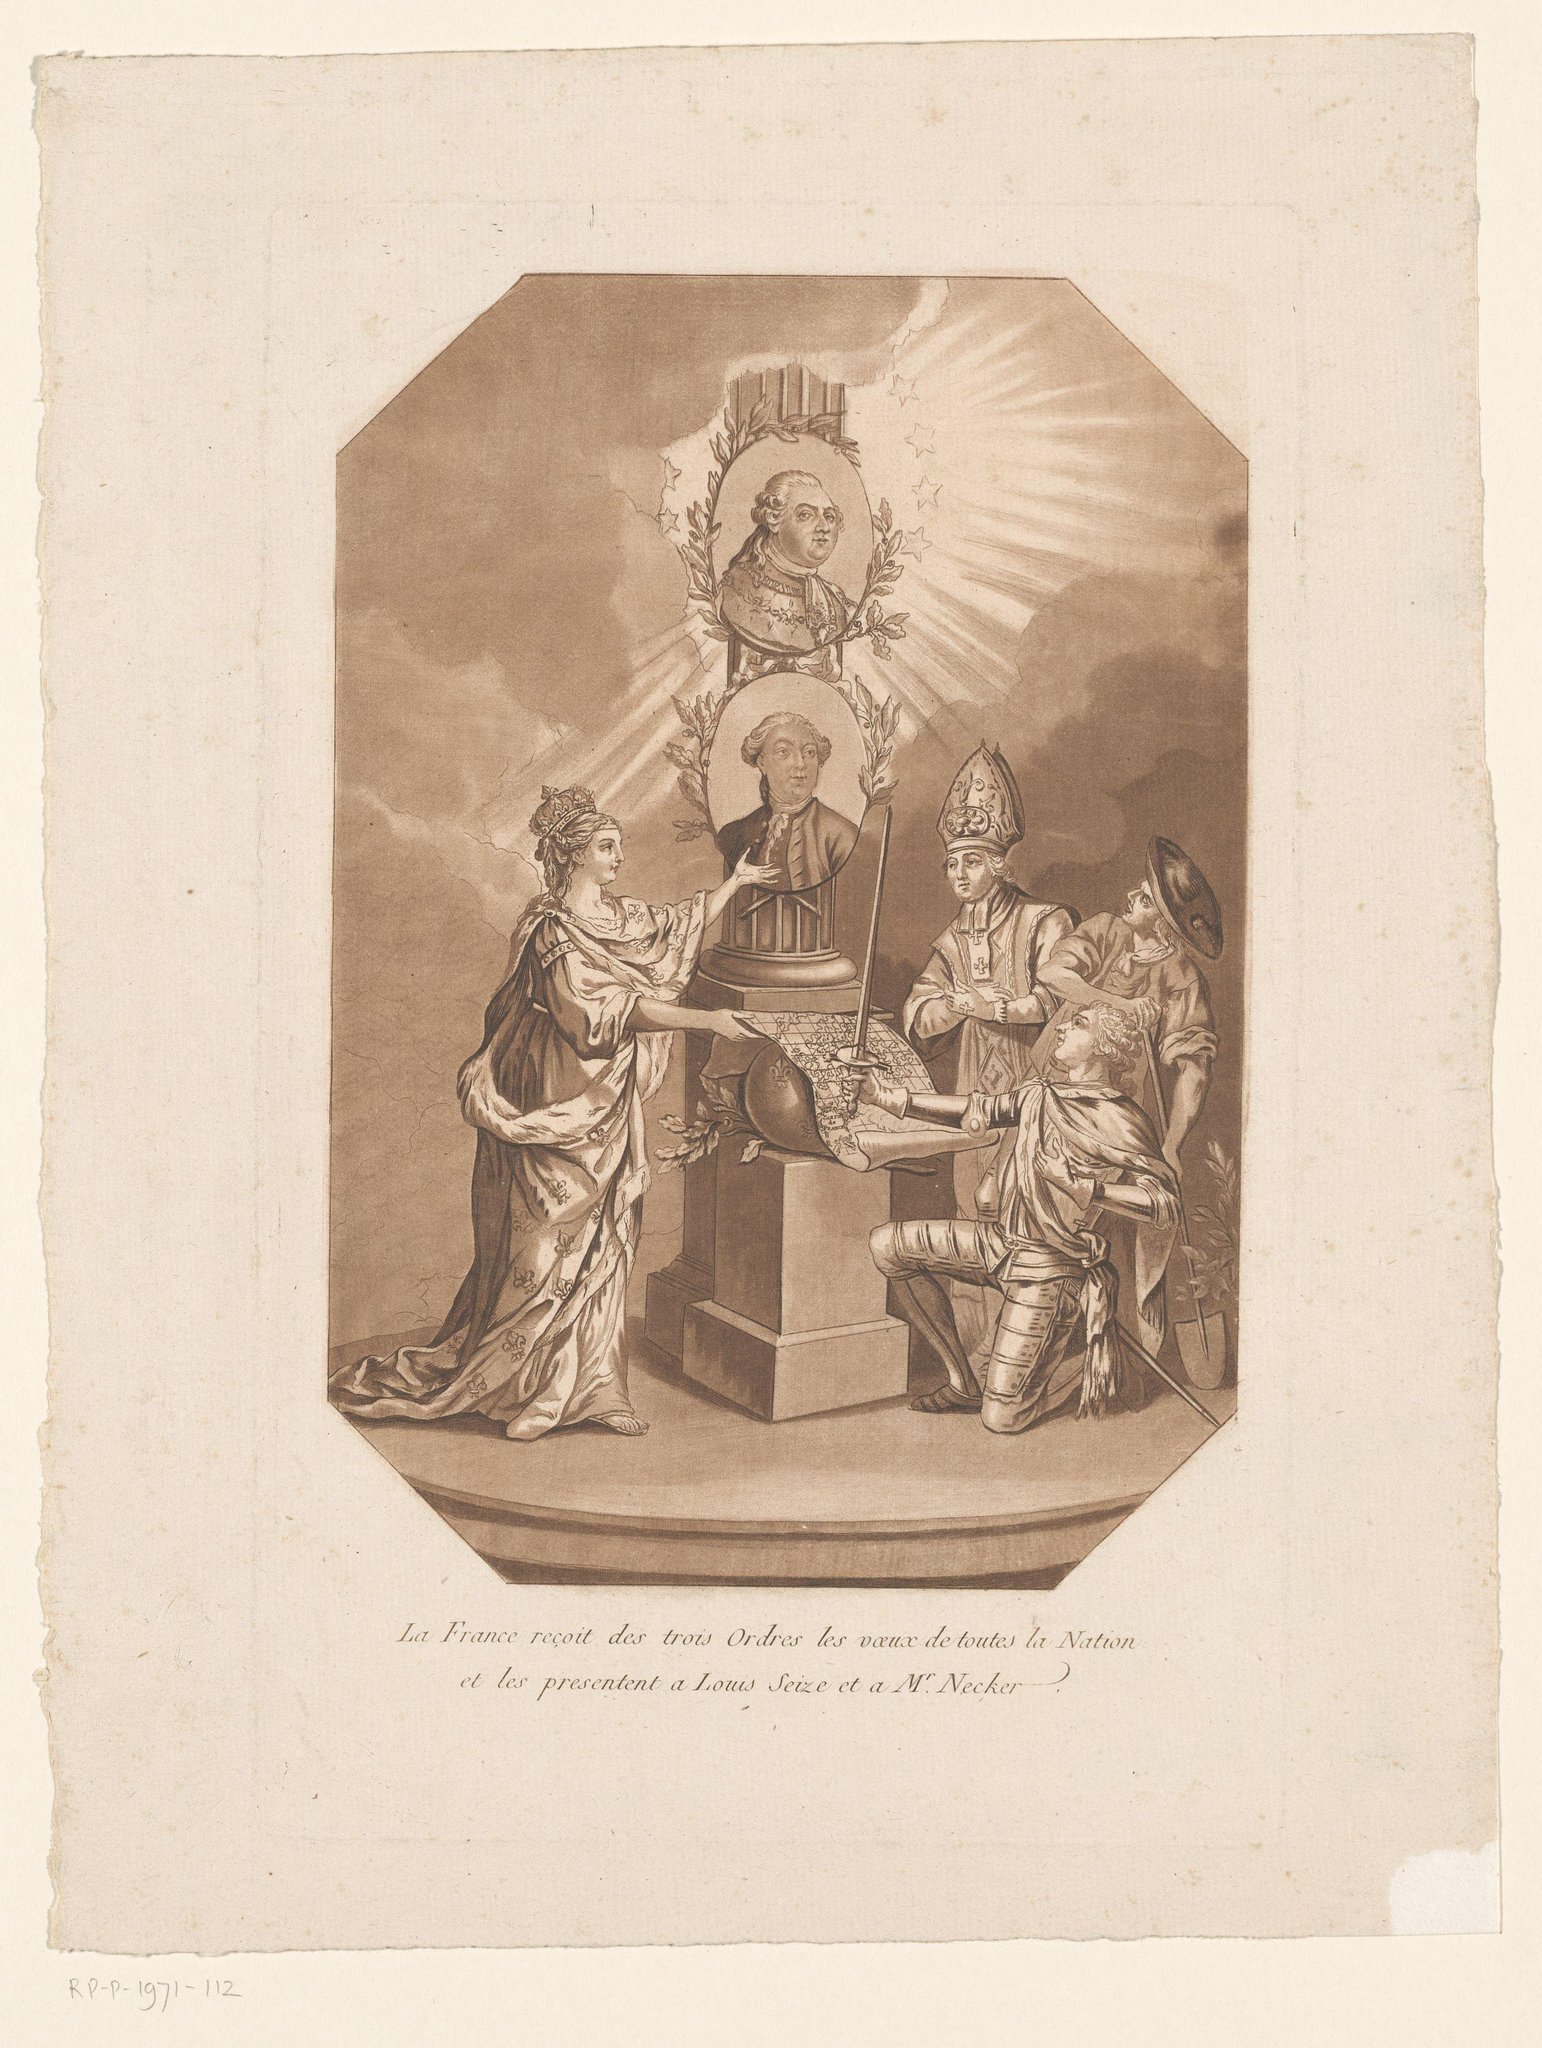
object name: print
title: La France reçoit des trois Ordres les voeux de toutes la Nation et les presentent a Louis Seize et a Mr. Necker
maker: Anonymous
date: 1781-1788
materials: paper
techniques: etching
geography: france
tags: paris, lodewijk xvi (koning van frankrijk), personifications of countries, nations, states, districts, etc., the three estates: nobility, clergy, commoners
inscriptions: collector's mark: Lugt 2760, collector's mark: Lugt 2228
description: Allegorie waarin Frankrijk eer ontvangt van de drie standen en hiervoor verwijst naar koning Lodewijk XVI en Jacques Necker, ca. 1781-1788.